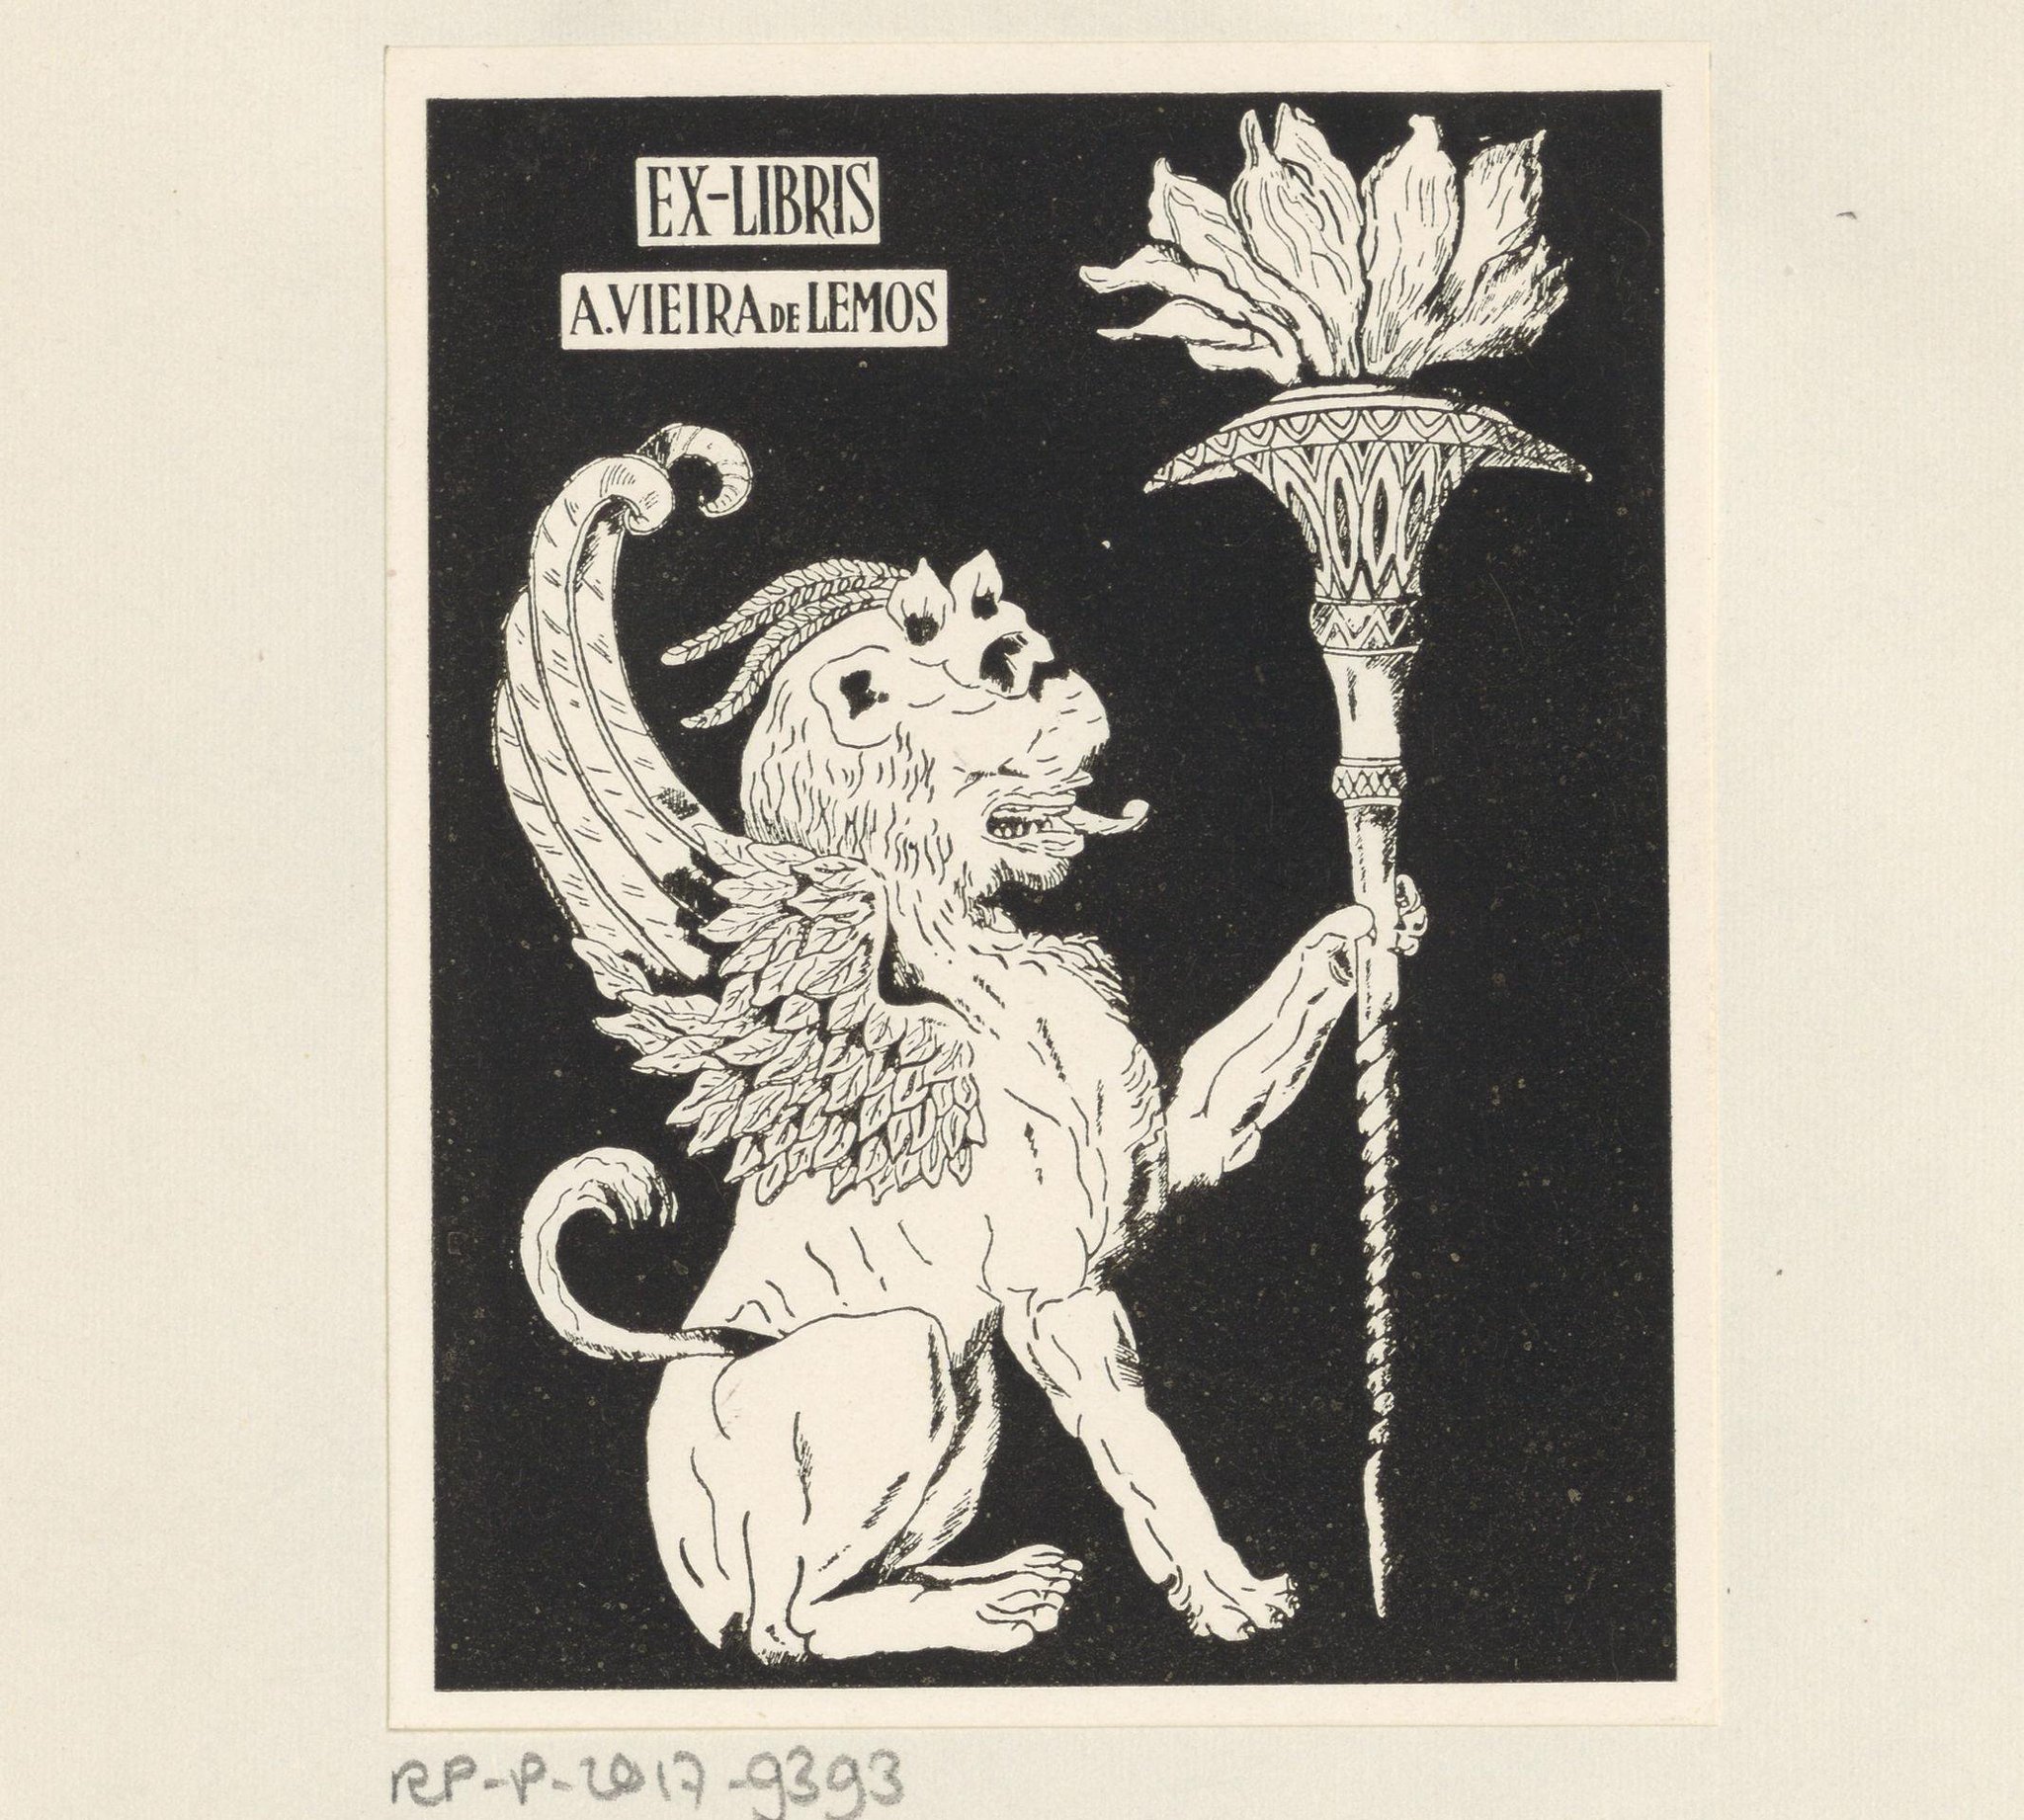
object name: bookplate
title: Ex libris van Anteno Vieira de Lemos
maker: Anonymous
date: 1880-1949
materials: paper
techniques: printing block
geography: portugal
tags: torch, sphinx (lion/woman); 'sfinge' (ripa)